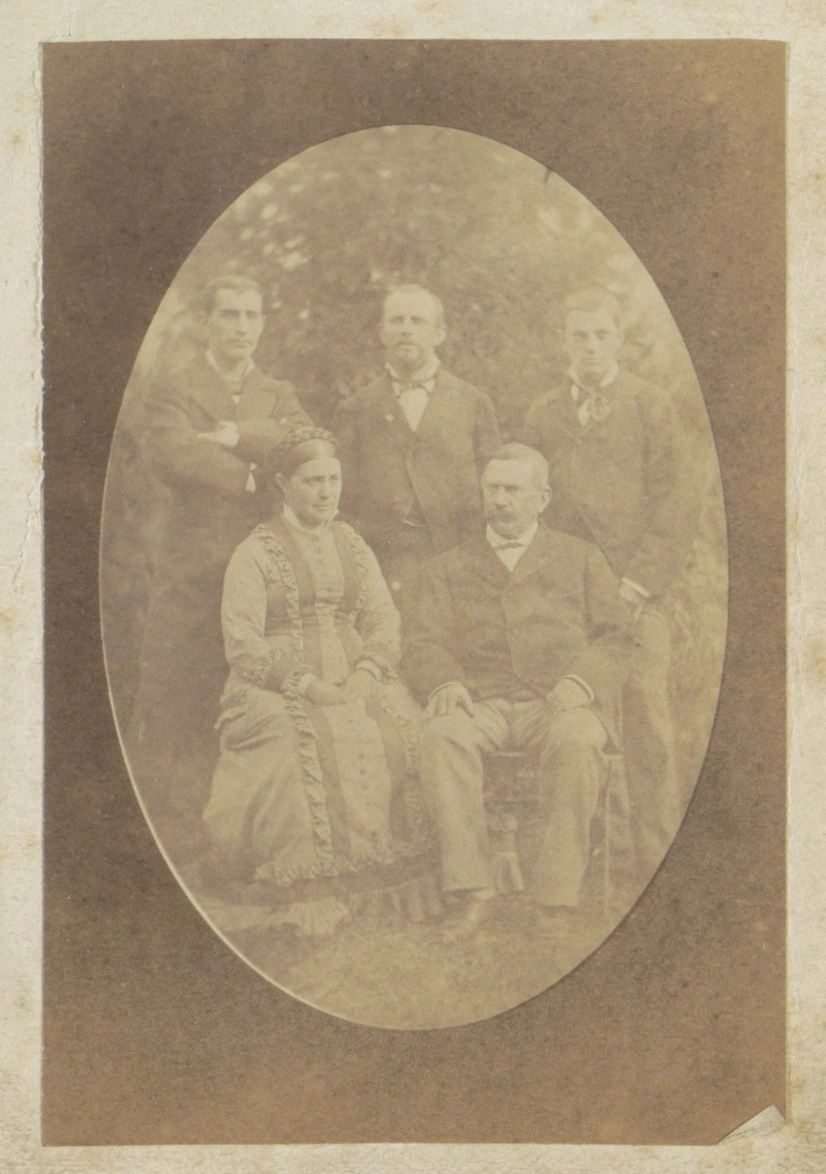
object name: photograph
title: Portret van een Française, zittend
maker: Anonymous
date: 1883-1886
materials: photographic support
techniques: albumen print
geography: france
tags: adult woman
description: Onderdeel van Album van een Franse amateurfotograaf met opnames van familie, militairen, industrie, landschappen en bezienswaardigheden in Frankrijk.